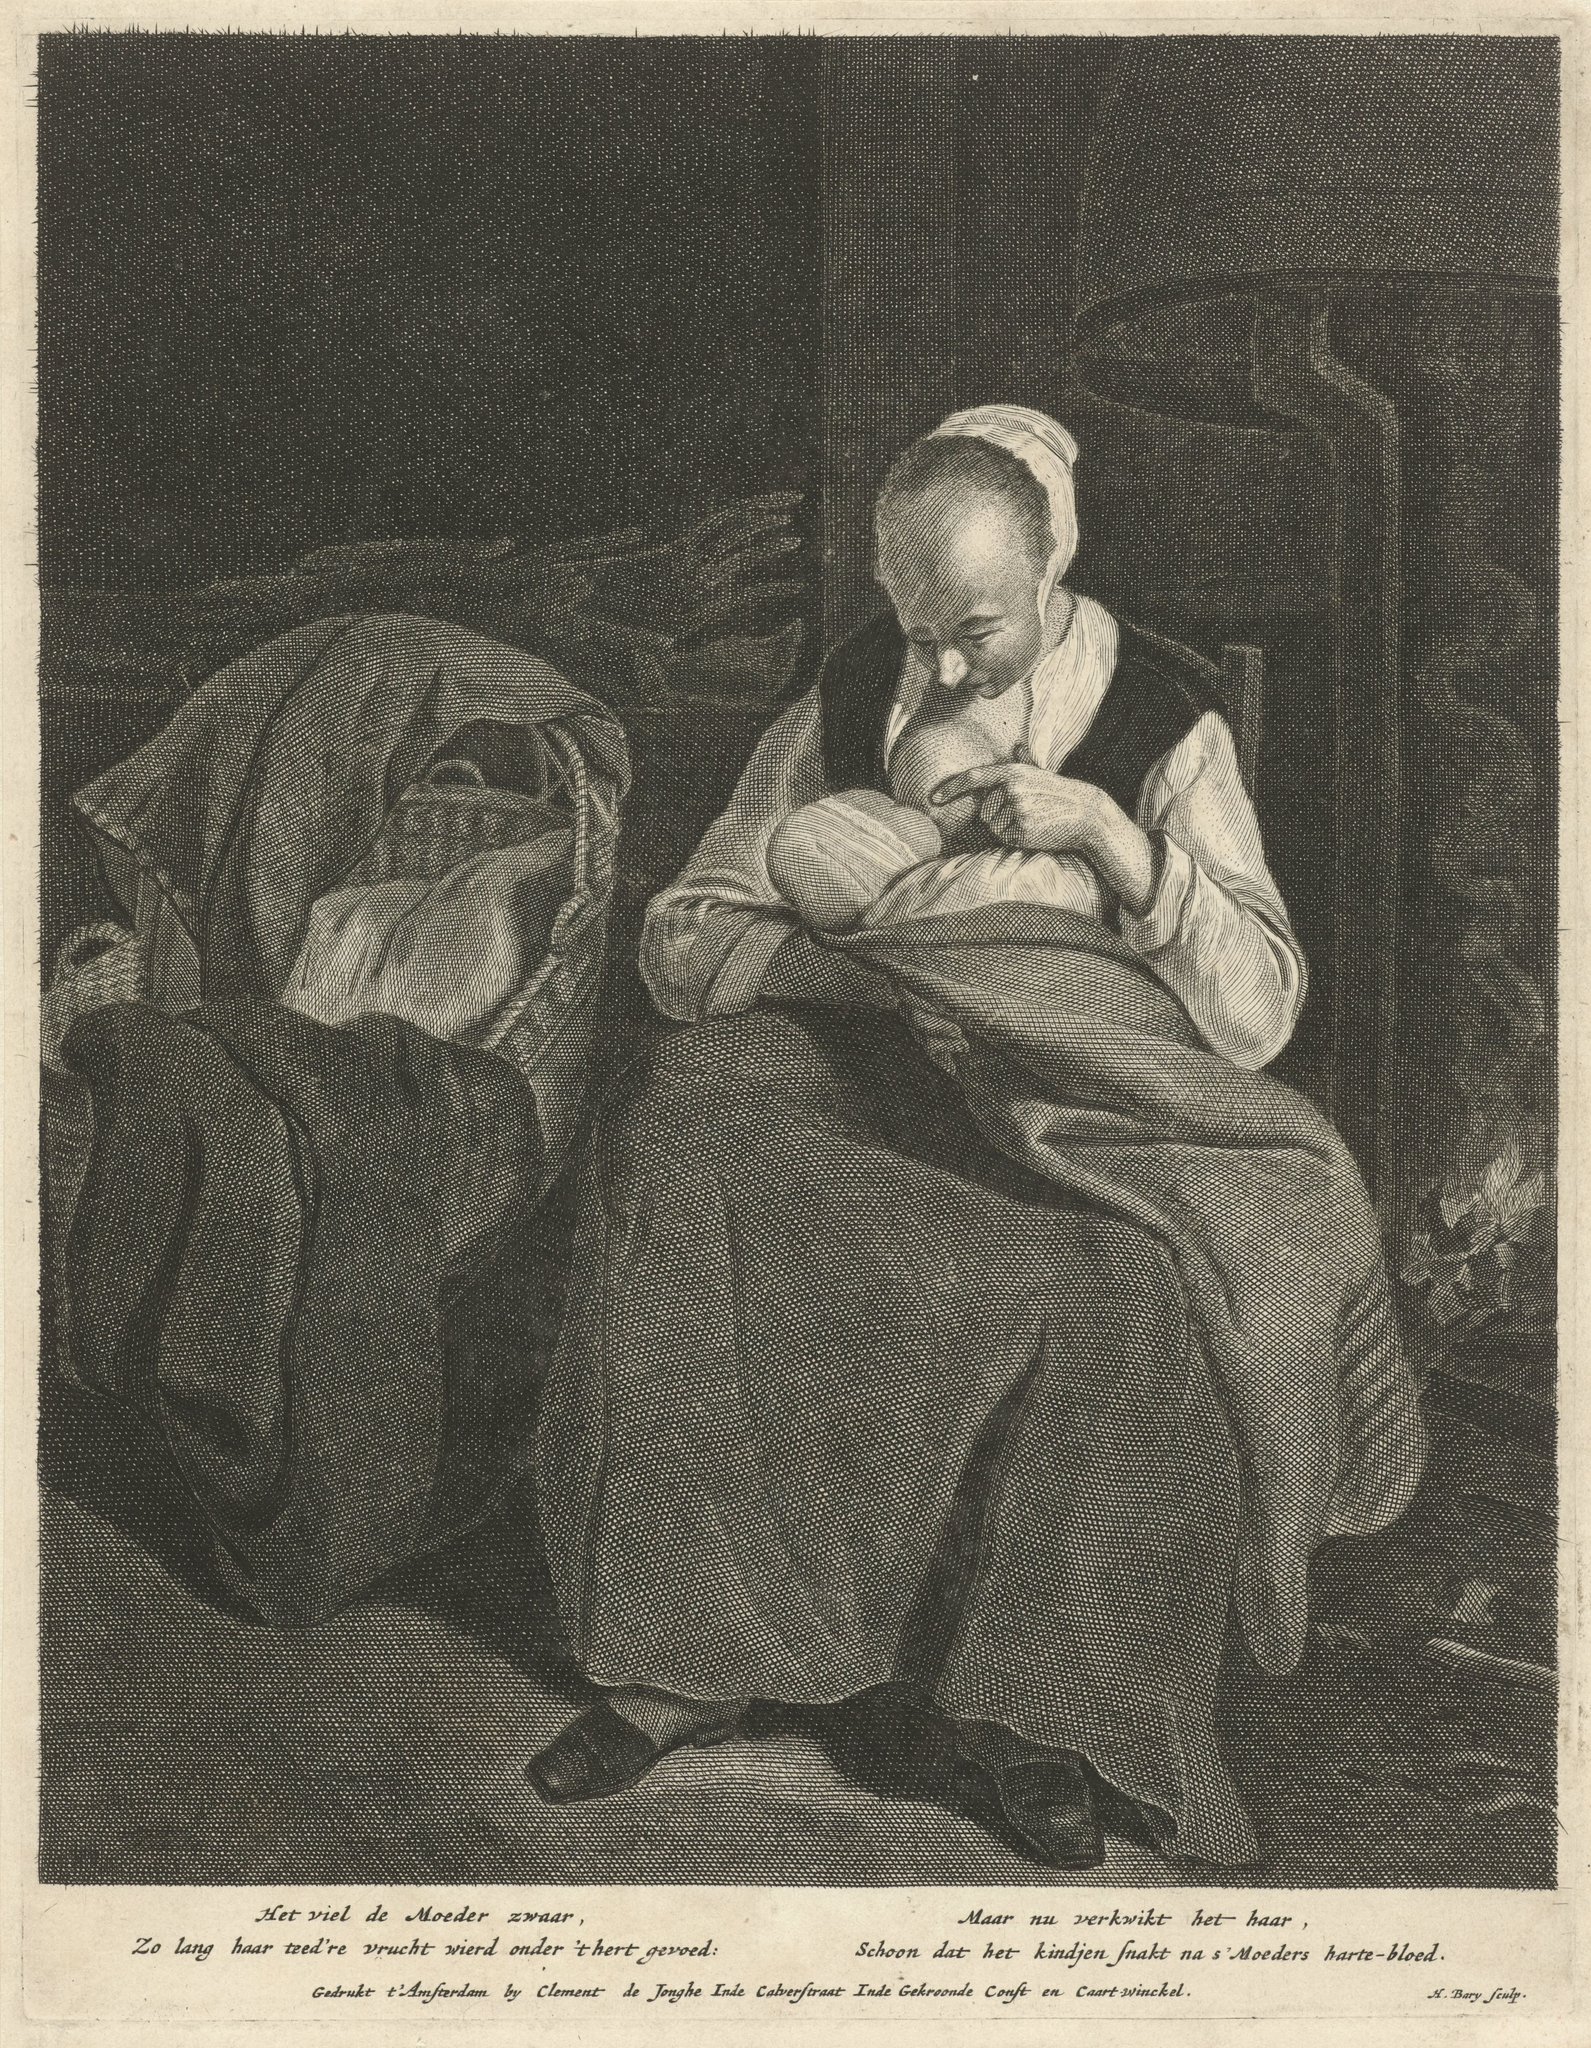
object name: print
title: Een vrouw voedt haar kind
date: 1657-1707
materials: paper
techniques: engraving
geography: amsterdam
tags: nursing, suckling, feeding a baby, cradle, crib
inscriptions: collector's mark: Lugt 2228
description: Een moeder zit naast de open haard haar kind te voeden. Naast haar staat een wieg.